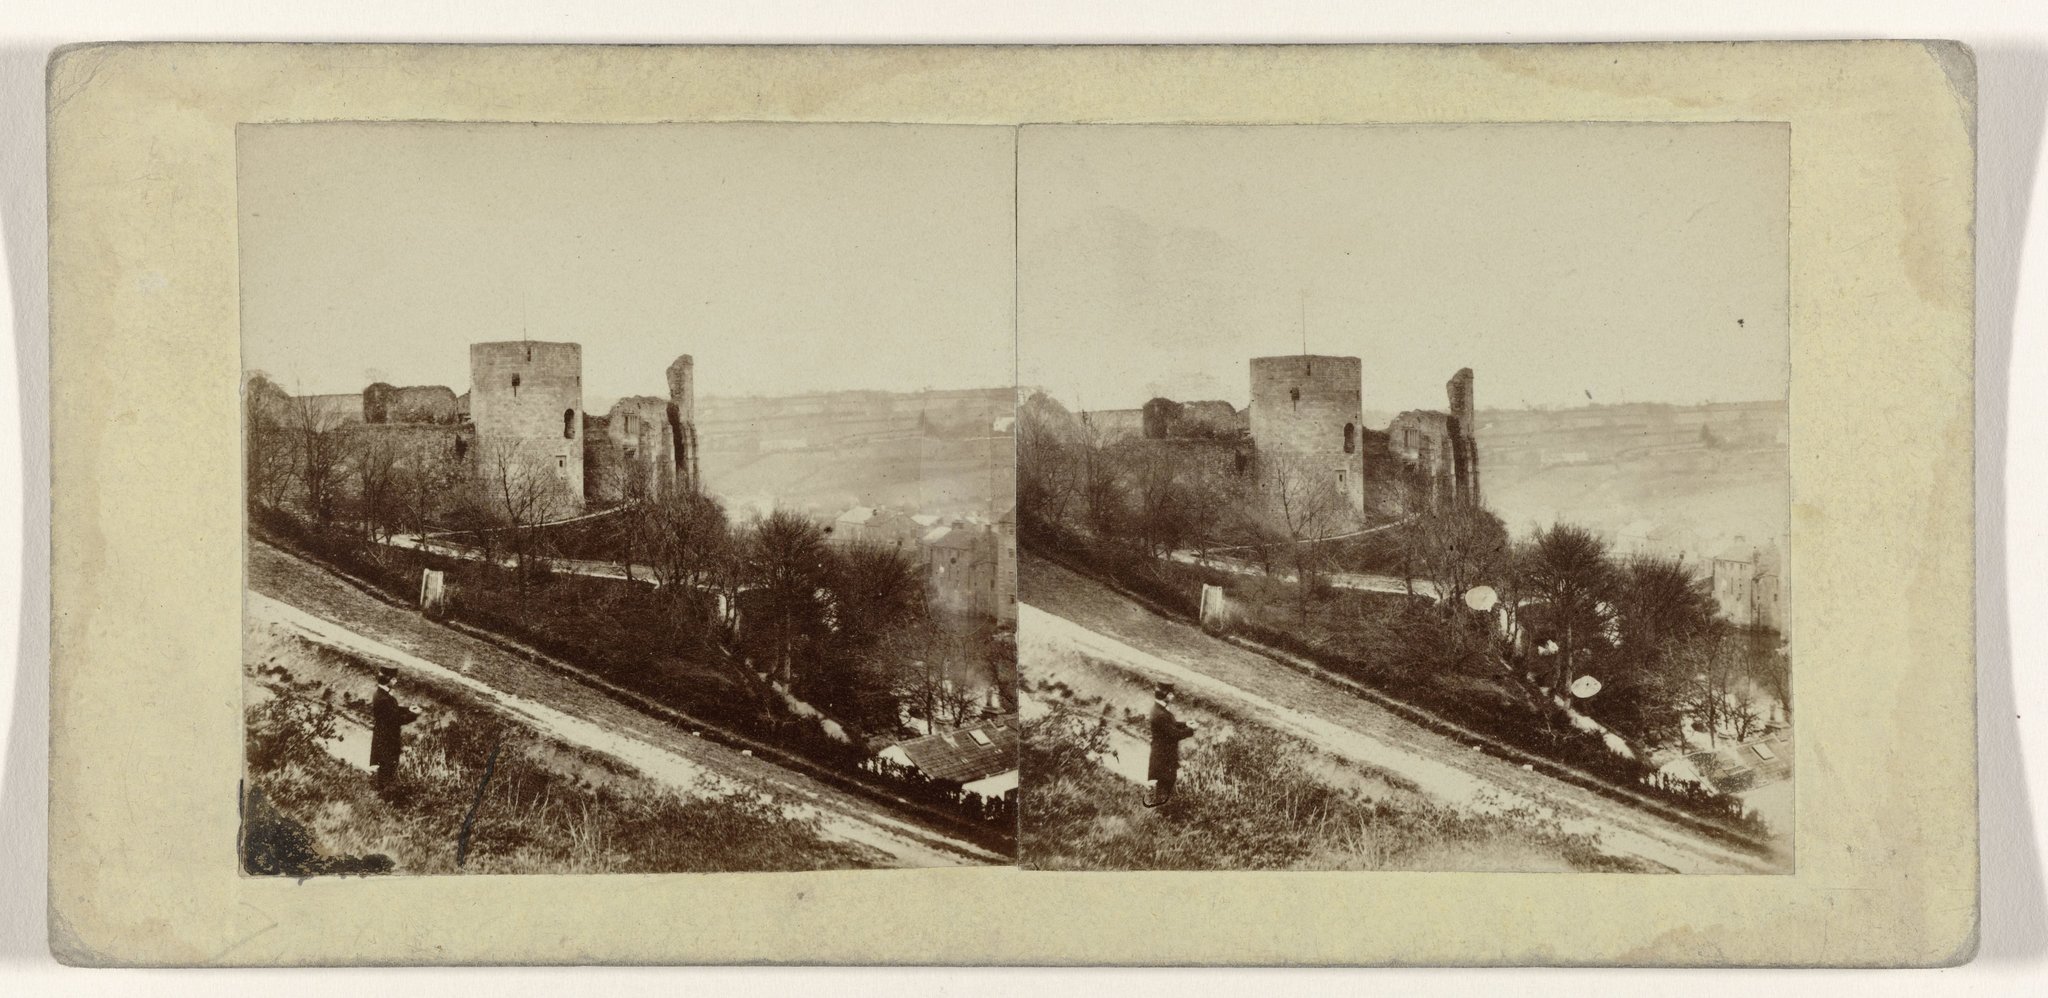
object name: stereograph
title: Baliols Tower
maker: Anonymous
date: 1861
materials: cardboard, paper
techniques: albumen print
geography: durham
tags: landscape with ruins (+ city(-scape) with figures, staffage)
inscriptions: number: ‘no. 1’